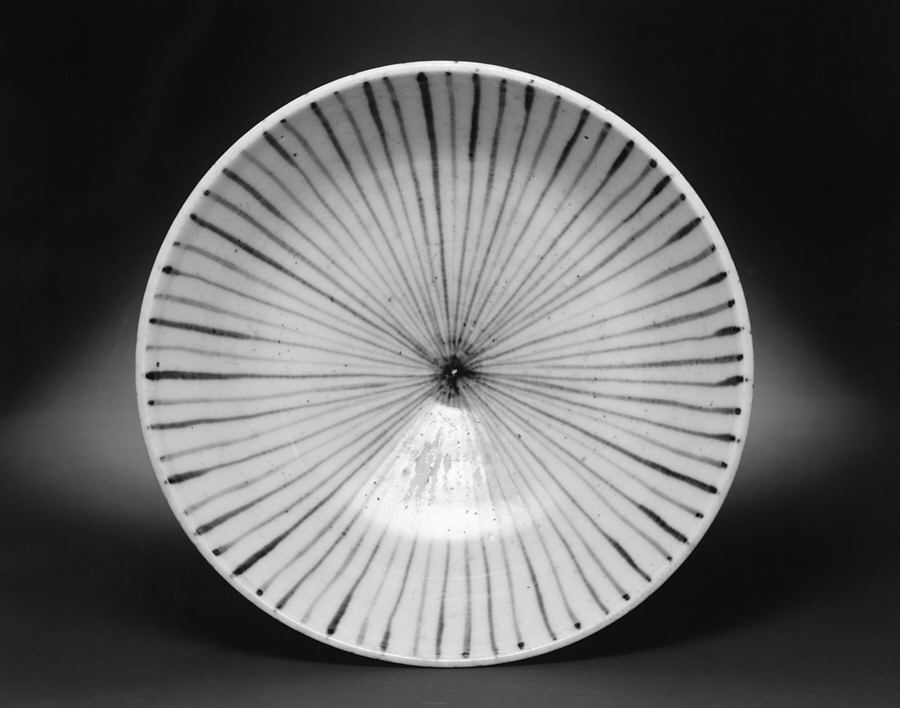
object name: bowl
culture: japanese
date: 1615-1868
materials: iron, porcelain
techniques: underglaze